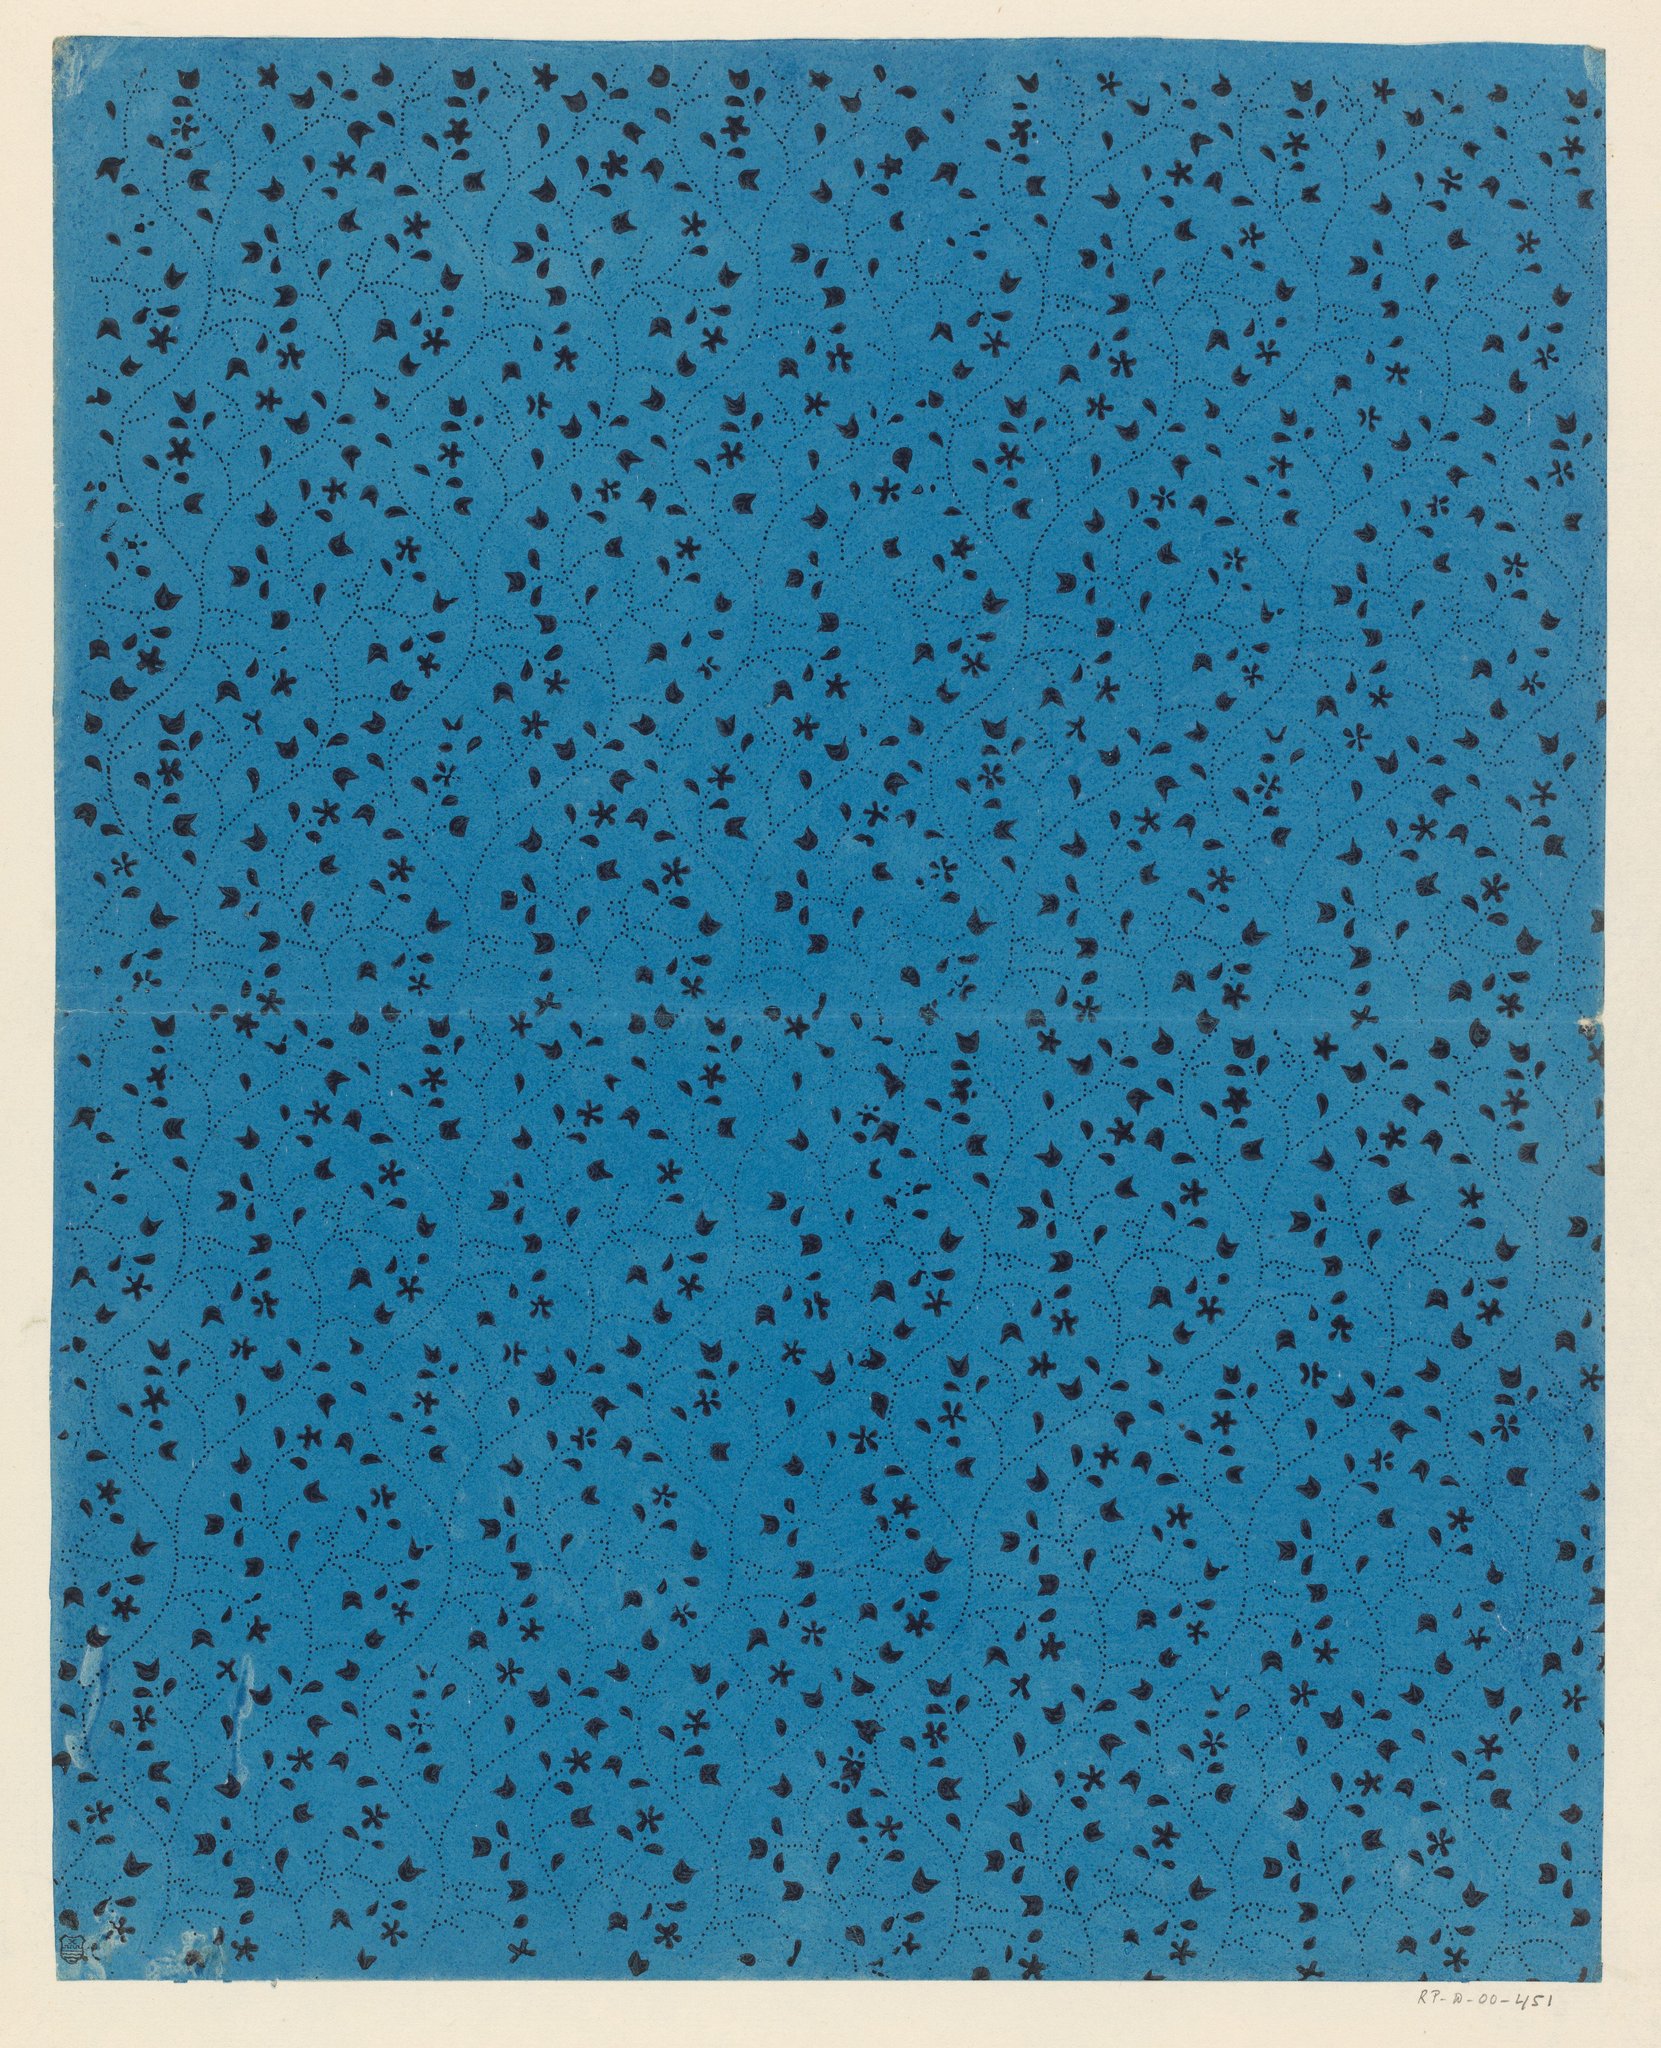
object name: printed paper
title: Blad met regelmatig slingerende ranken van punten met blaadjes en bloemen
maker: Anonymous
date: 1800-1900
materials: paint, paper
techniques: printing block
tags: ornament derived from plant forms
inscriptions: collector's mark: Lugt 2760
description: Blad met regelmatig over het blad slingerende ranken bestaande uit punten met blaadjes en bloemen.